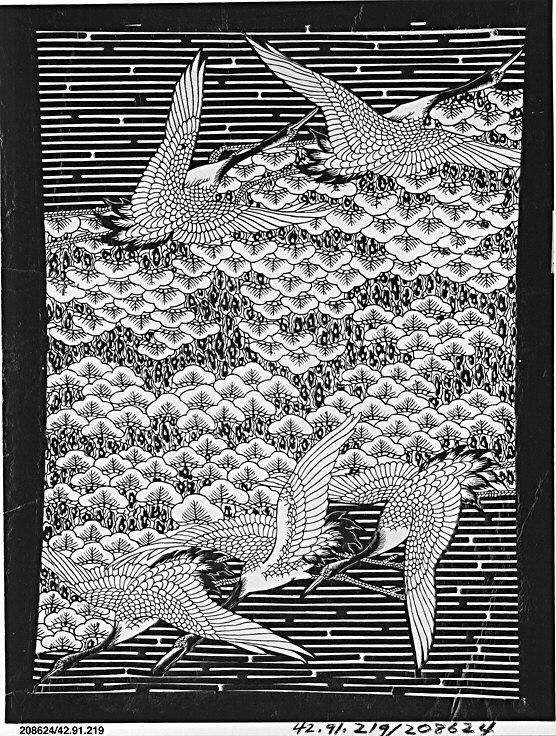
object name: stencil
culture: japanese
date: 1868-1912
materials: paper, silk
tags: cranes